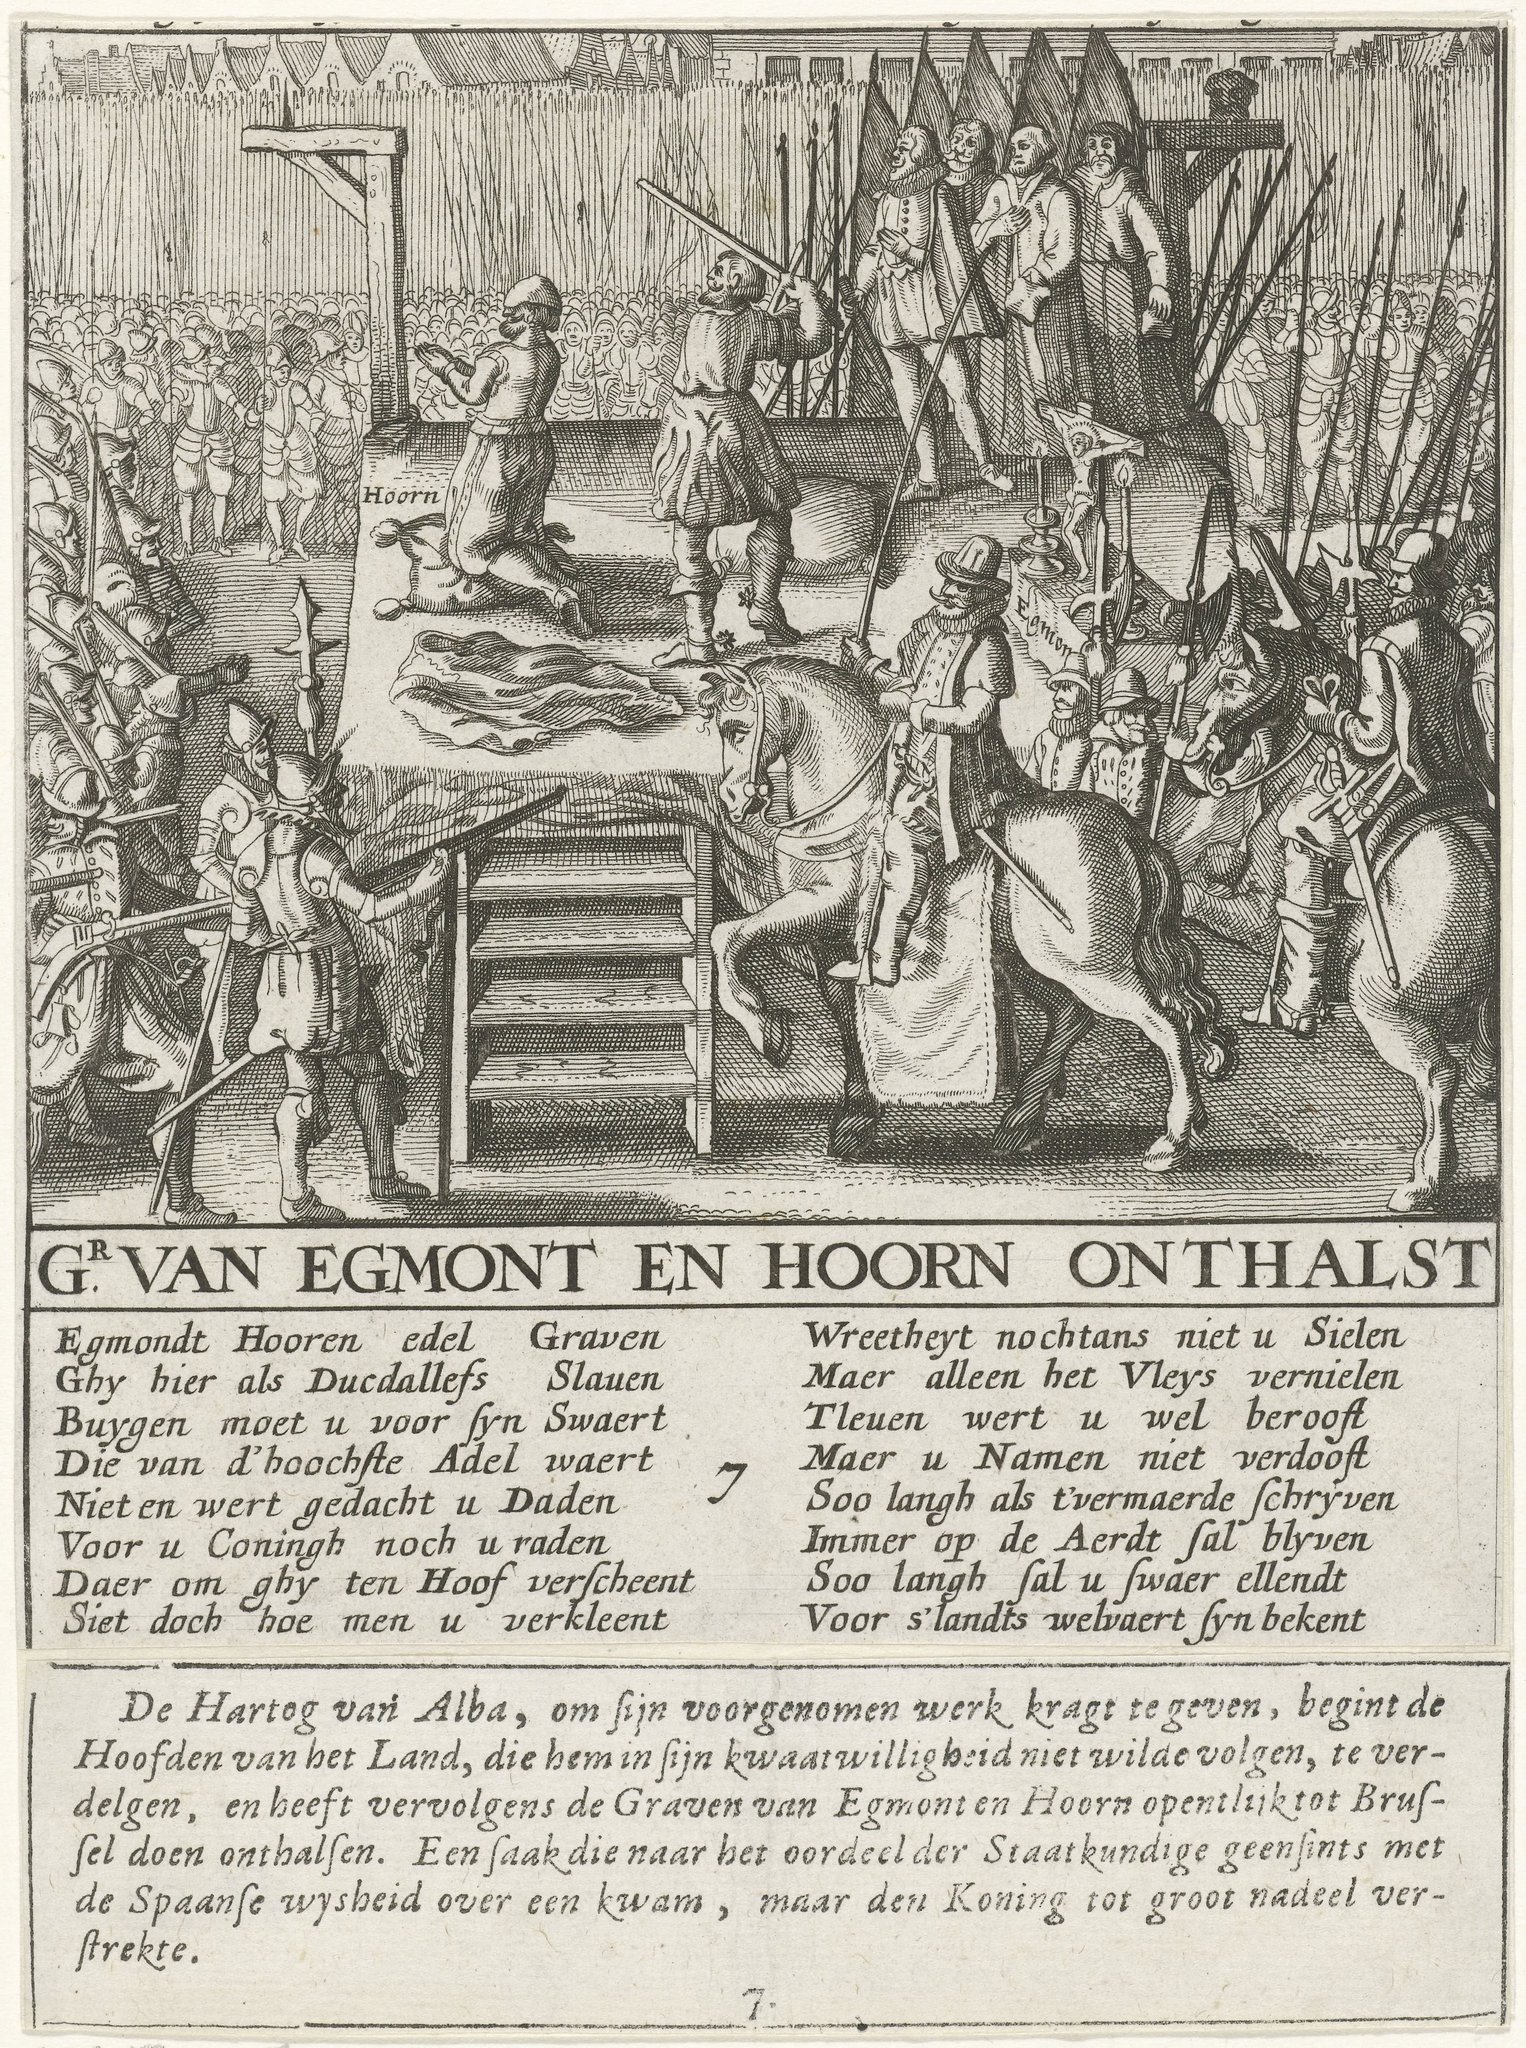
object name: print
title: De onthoofding van Egmont en Horne in 1568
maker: Anonymous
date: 1618-1624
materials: paper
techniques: etching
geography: northern netherlands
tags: fernando álvarez de toledo (3rd duke of alba), brussels, earl, on the scaffold or place of execution, violent death by beheading, historical events and situations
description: Illustratie voor een (onbekende) uitgave van het populaire en vaak herdrukte werk getiteld: De Spaensche Tiranye gheschiet in Nederlant, waarschijnlijk voor het eerst ca. 1620 verschenen. Zie ook Hollstein (Dutch), vol. XXXVIII (Claes Jansz. Visscher II), p. 165, nr. 425 en een andere versie van dit werk uitgegeven in 1621 te Amsterdam bij C.L. vander Plasse, in de collectie van de Rijksmuseum Research Library, signatuur 327 K 30.